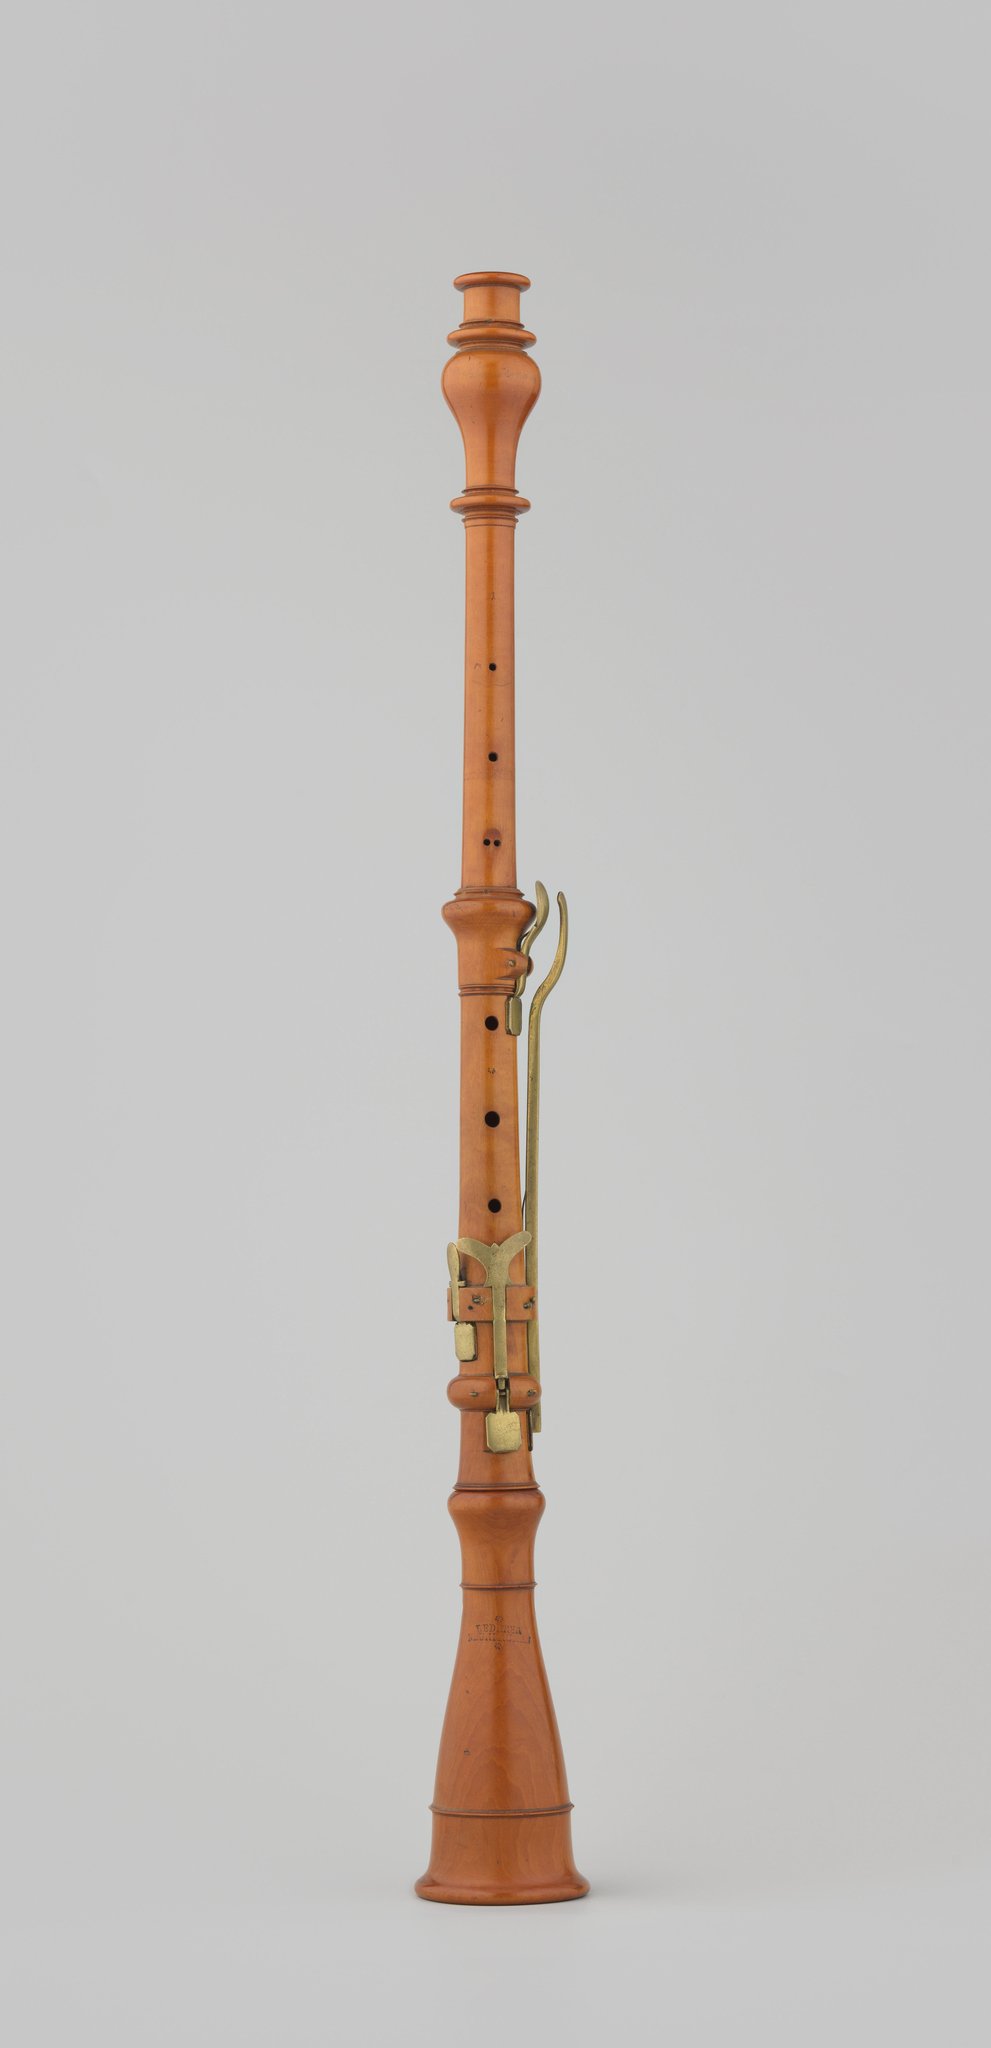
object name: wind instrument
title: Oboe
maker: christian gottlob lederer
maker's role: musical instrument maker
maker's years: 1764-1829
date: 1800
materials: wood, brass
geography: neukirchen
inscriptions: inscription: ‘[zon] / LEDERER / NEUKIRCHEN / [zon].’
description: Hobo van palmhout met vier messing kleppen. Het derde gat is dubbel. Gemarkeerd met het cijfer 1 op het bovenste gedeelte en een zon op het middelste gedeelte. Op de beker gemarkeerd met: [zon] / LEDERER / NEUKIRCHEN / [zon]. Twee stemgaten in de beker.